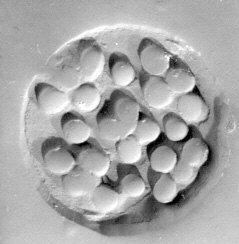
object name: stamp seal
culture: bactria-margiana archaeological complex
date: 2333-1668 BCE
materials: limestone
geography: bactria-margiana